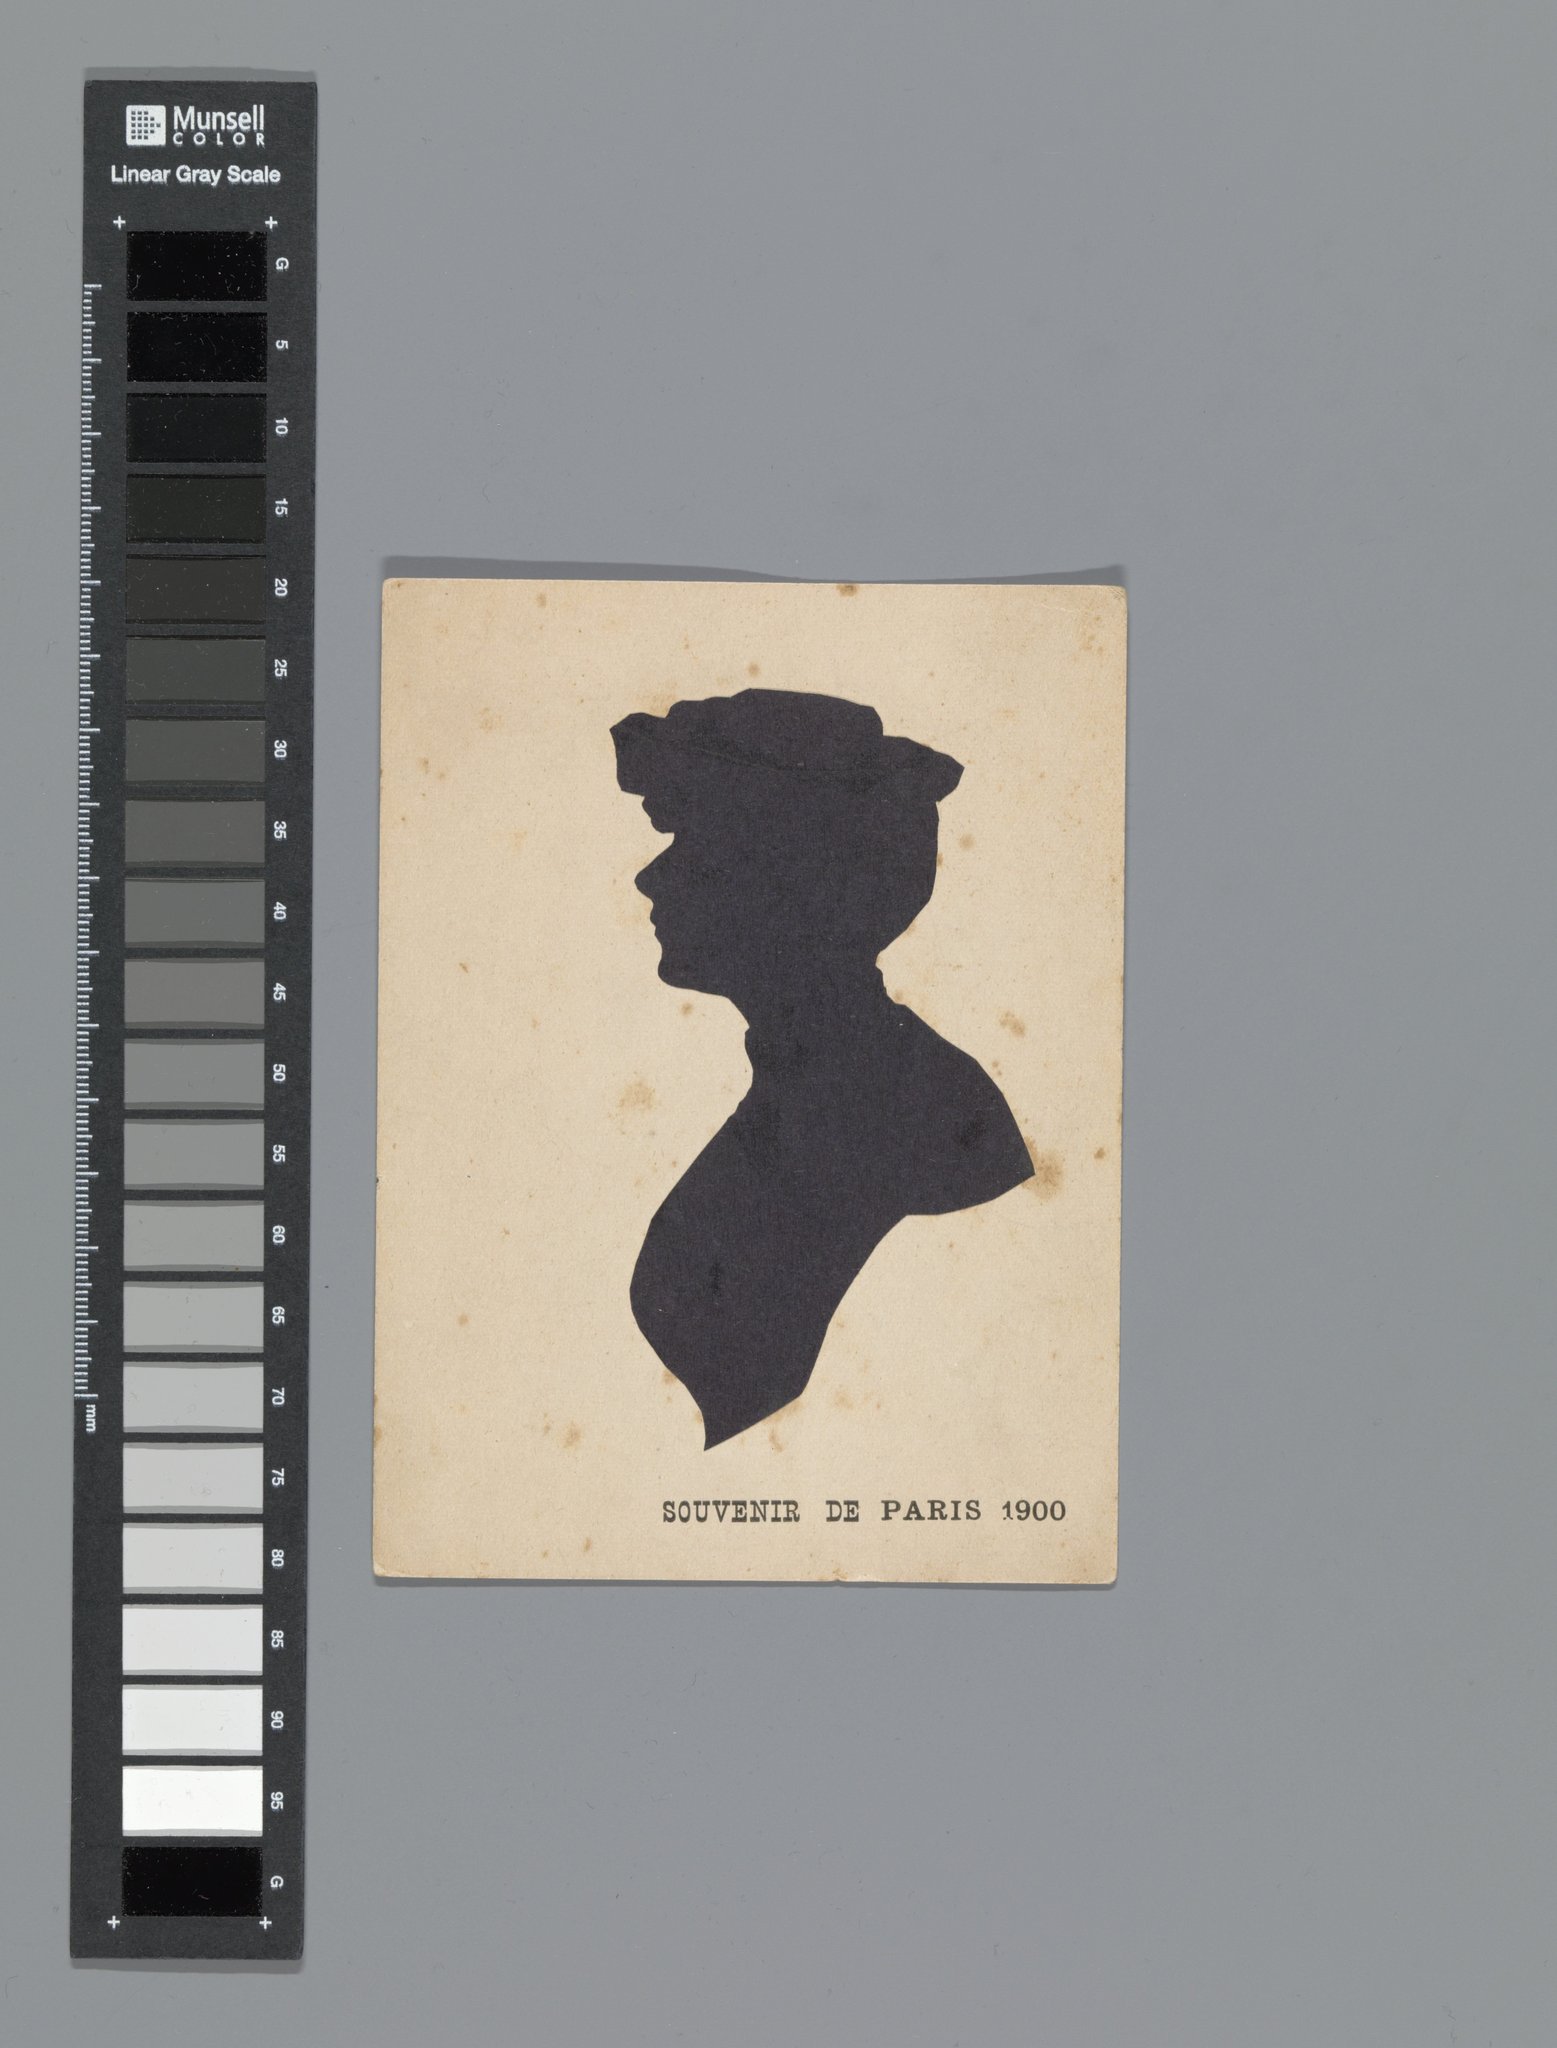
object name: collage visual work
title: Silhouet van een vrouw (Parijs)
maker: Anonymous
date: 1860-1915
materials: paper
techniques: collage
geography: paris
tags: paris